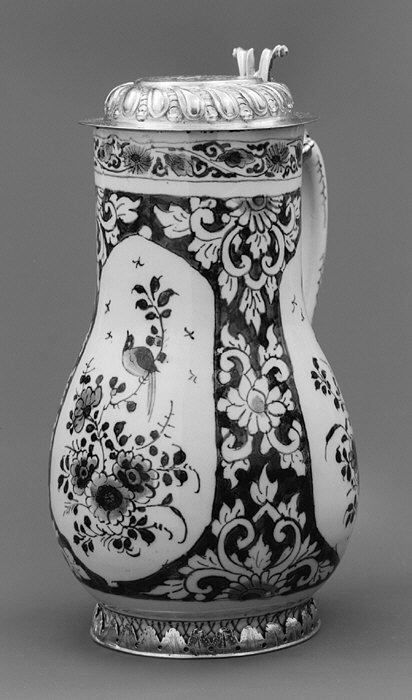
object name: tankard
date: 1701-1800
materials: earthenware, silver gilt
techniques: glazing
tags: birds,flowers